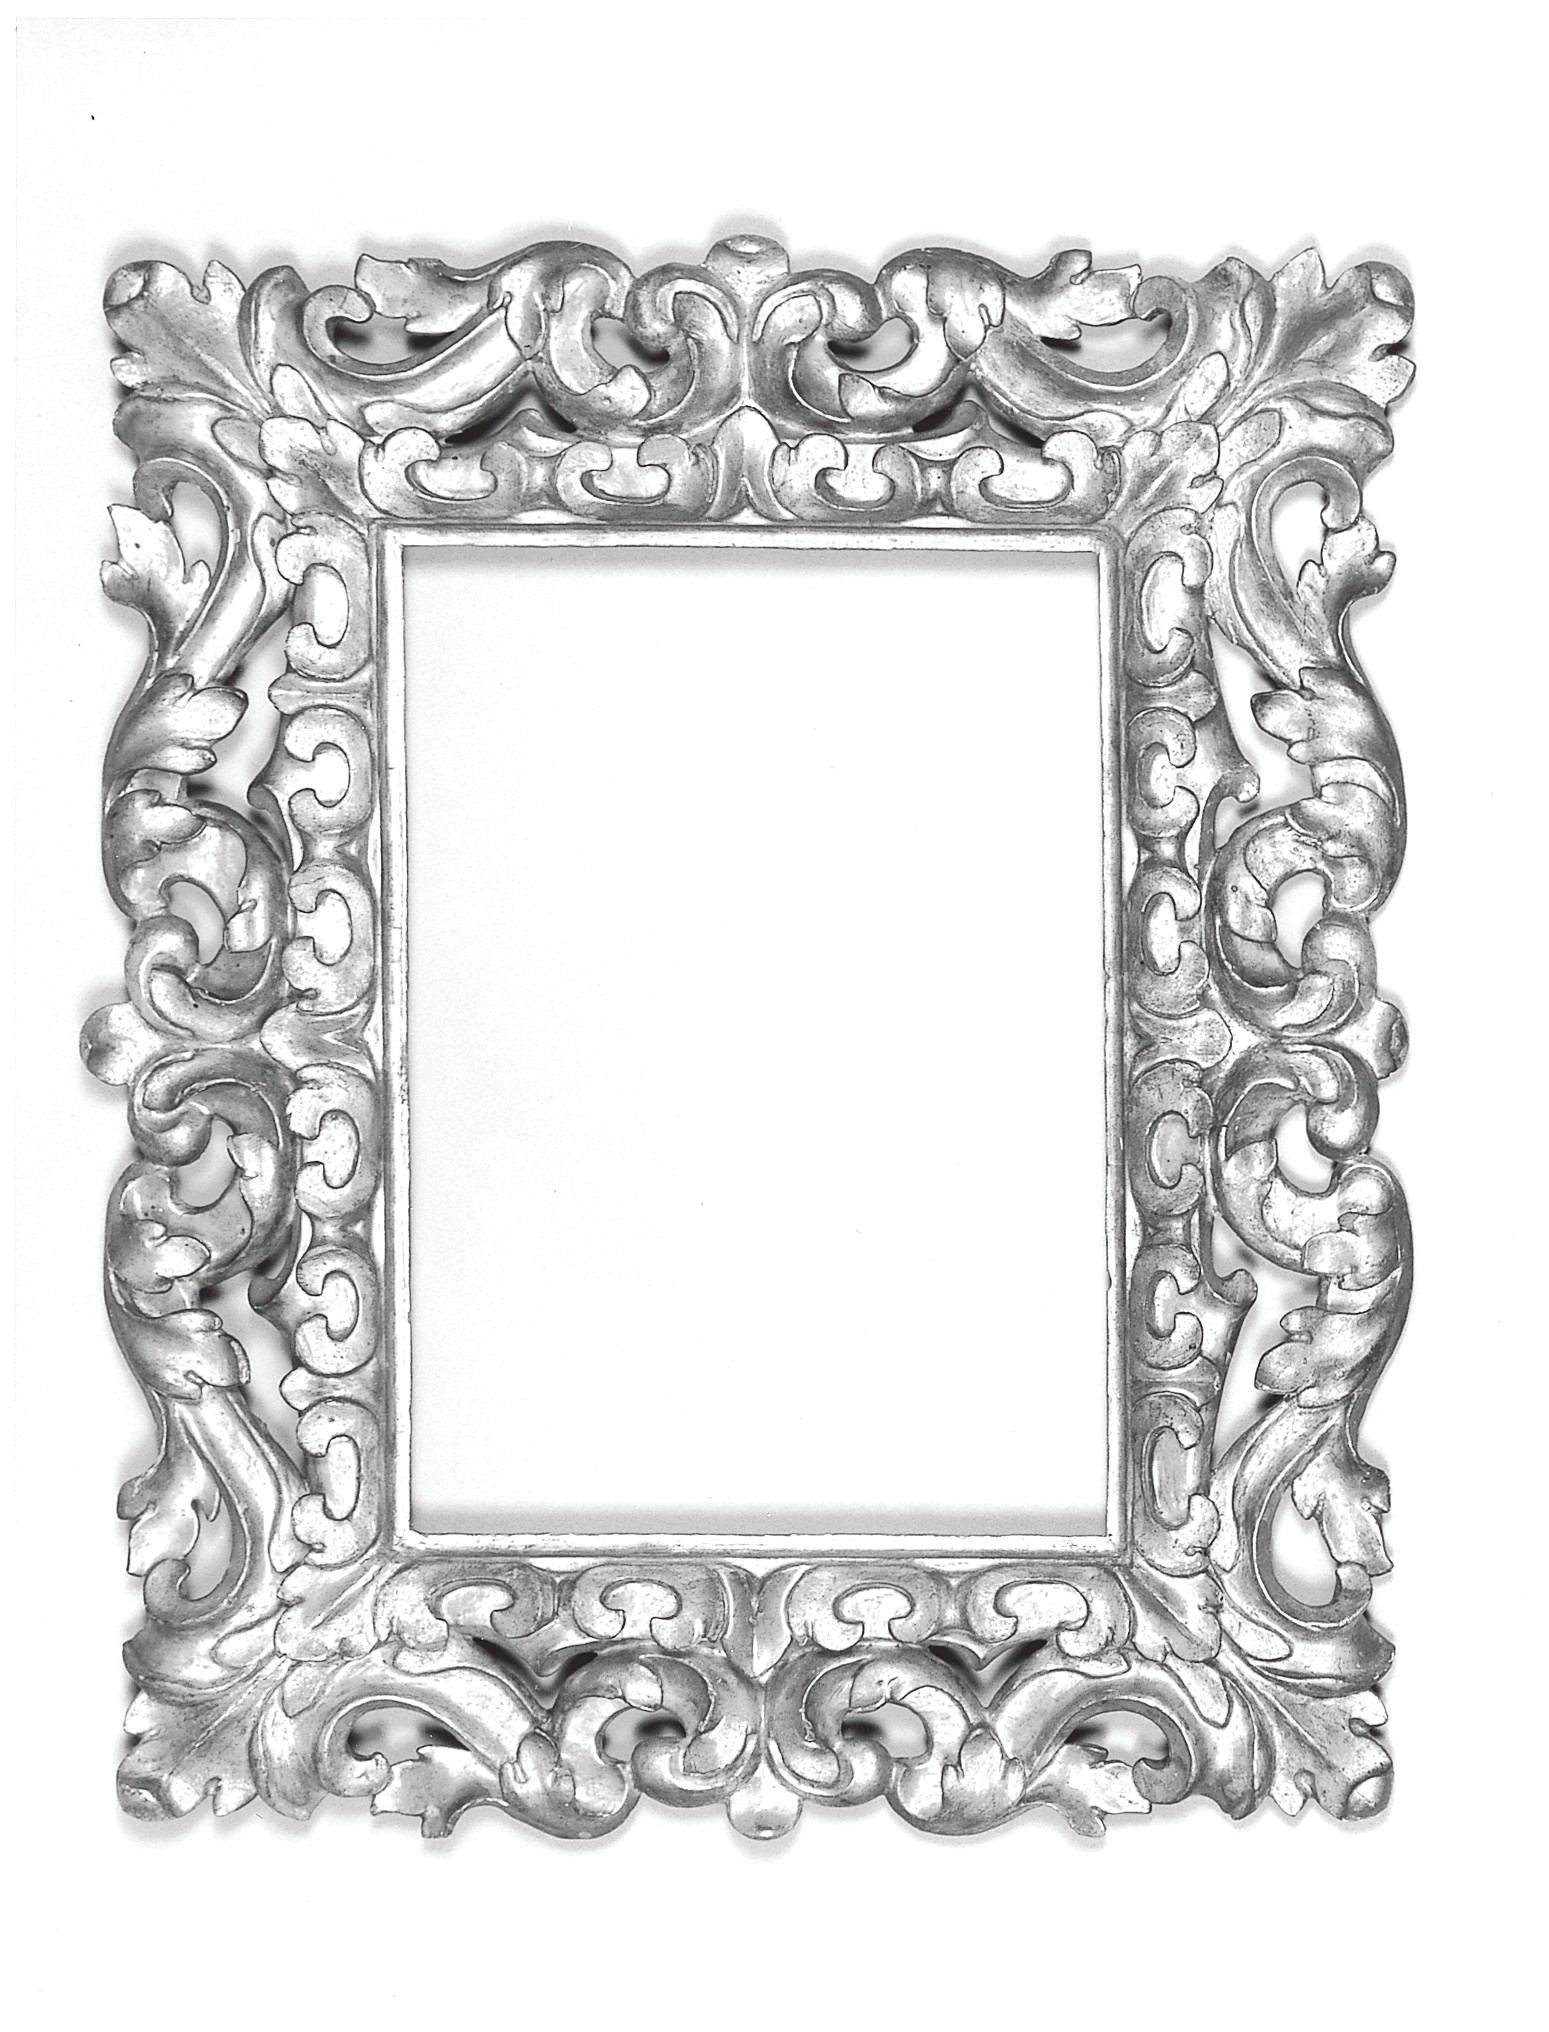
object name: frame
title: Palatina-style Salvator Rosa frame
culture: southern italian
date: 1767-1800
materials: wood